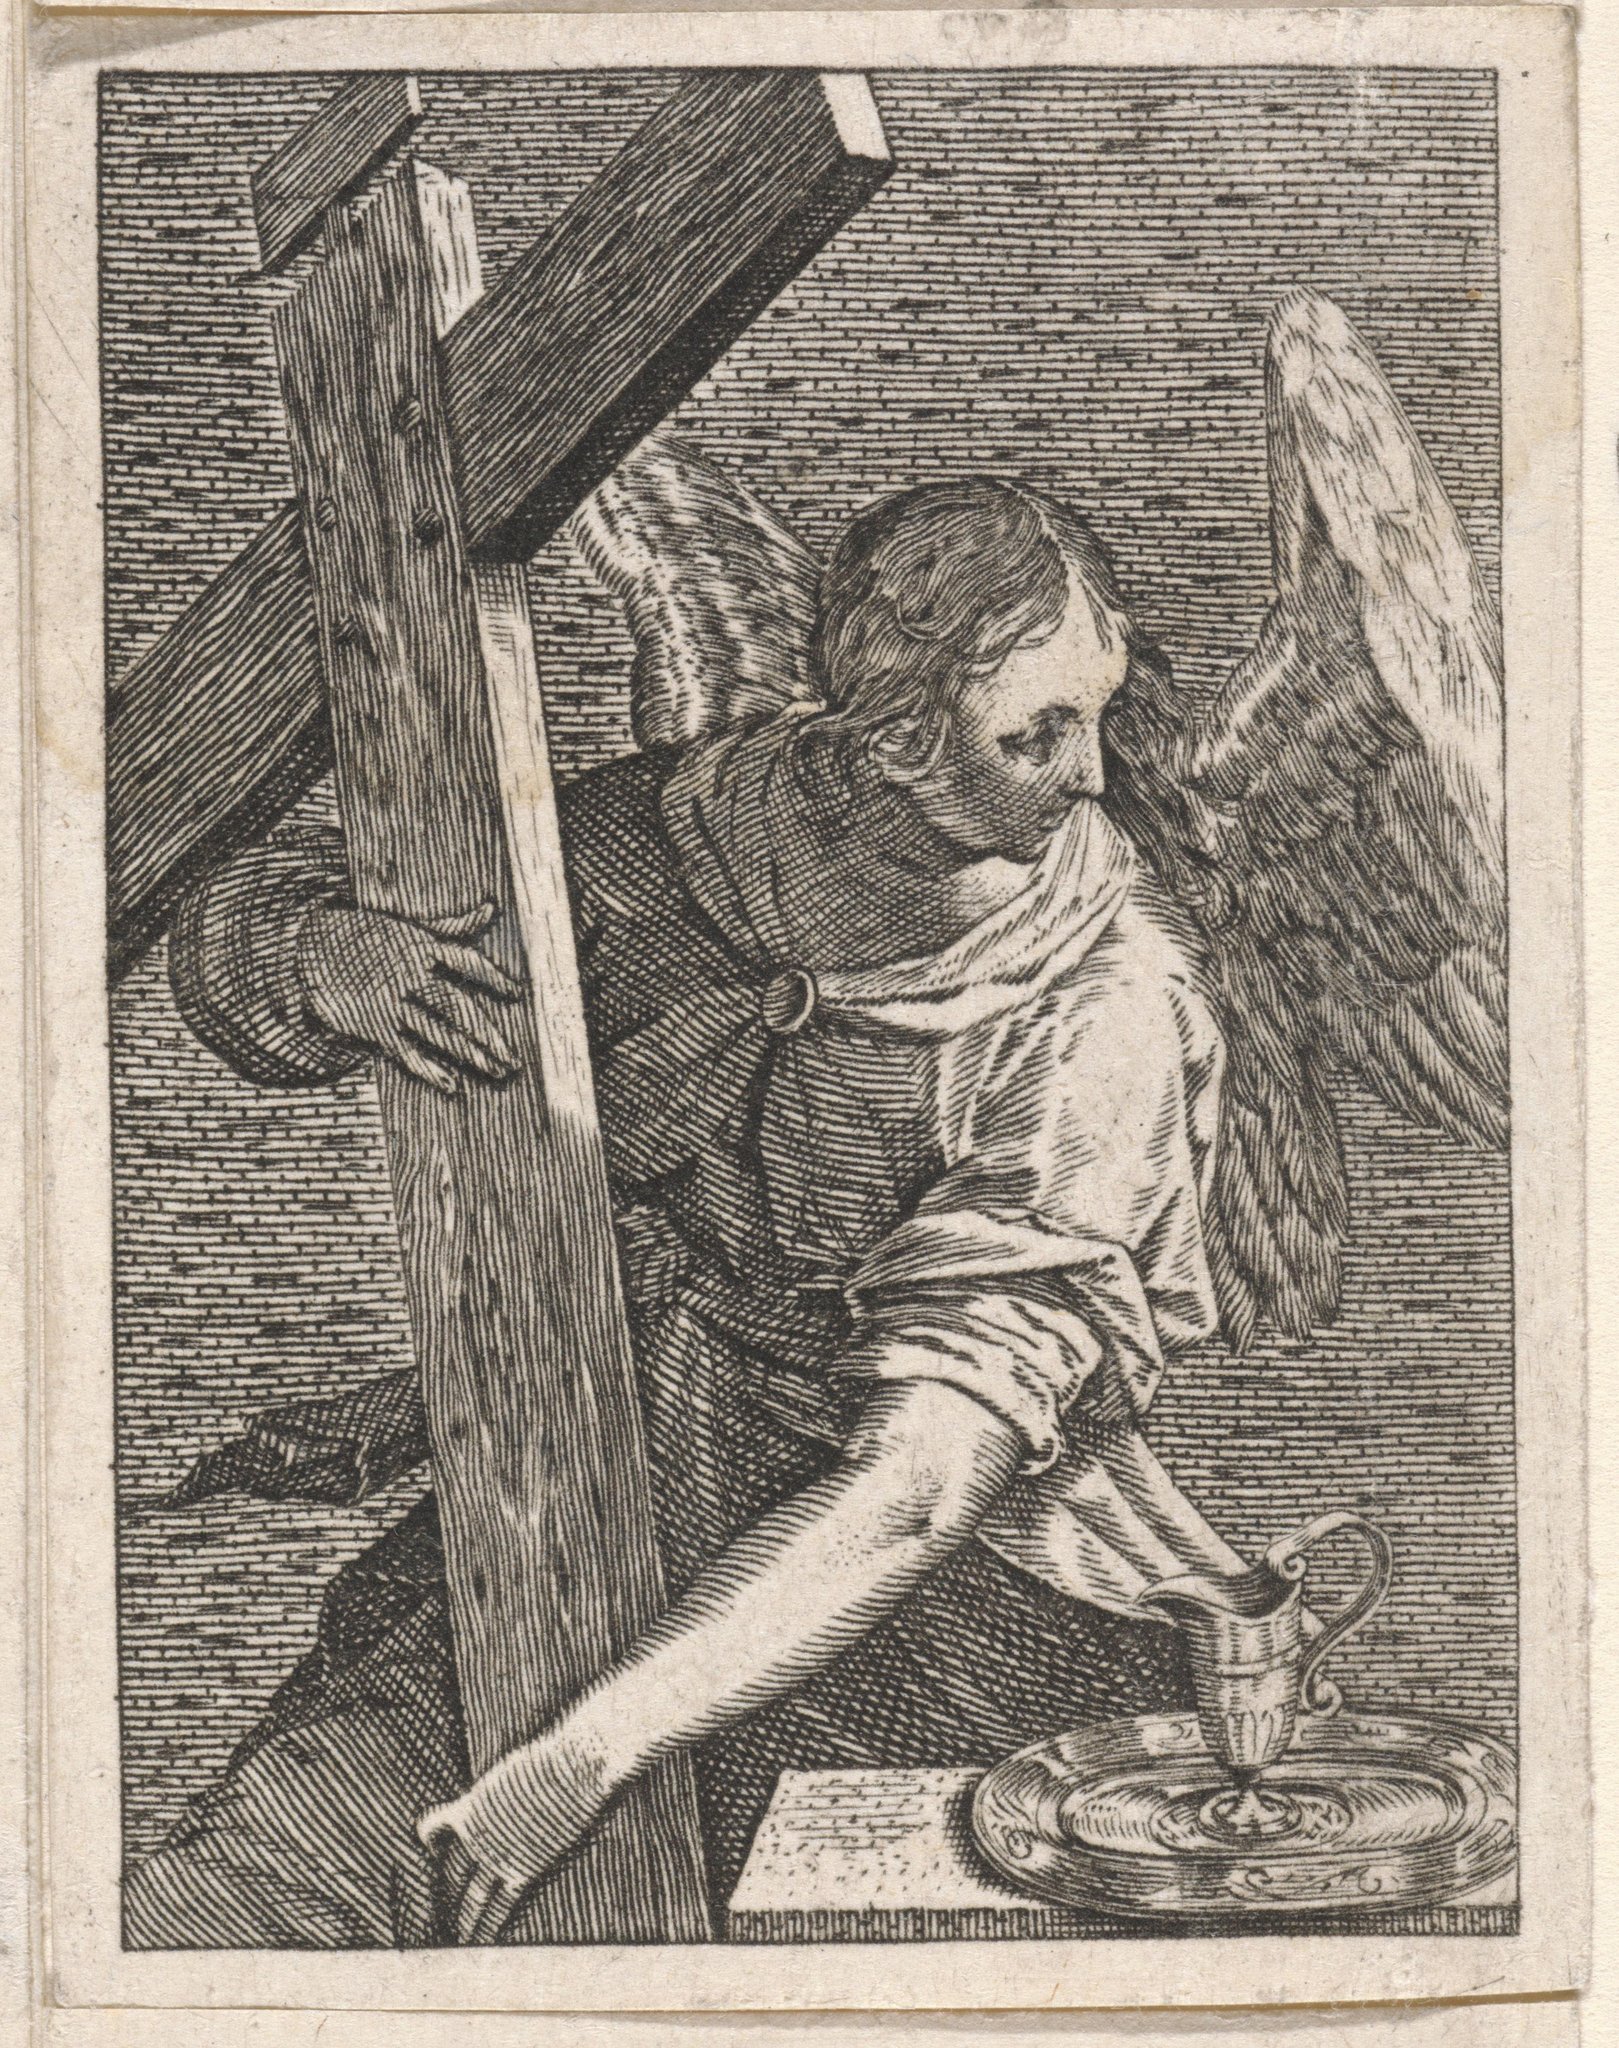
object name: print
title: Engel met het kruis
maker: johann sadeler (i)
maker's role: print maker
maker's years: 1550-1600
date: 1580-1600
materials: paper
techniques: engraving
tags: single instruments of the passion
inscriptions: collector's mark: Lugt 240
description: Passiewerktuigen zijn kopie in spiegelbeeld.